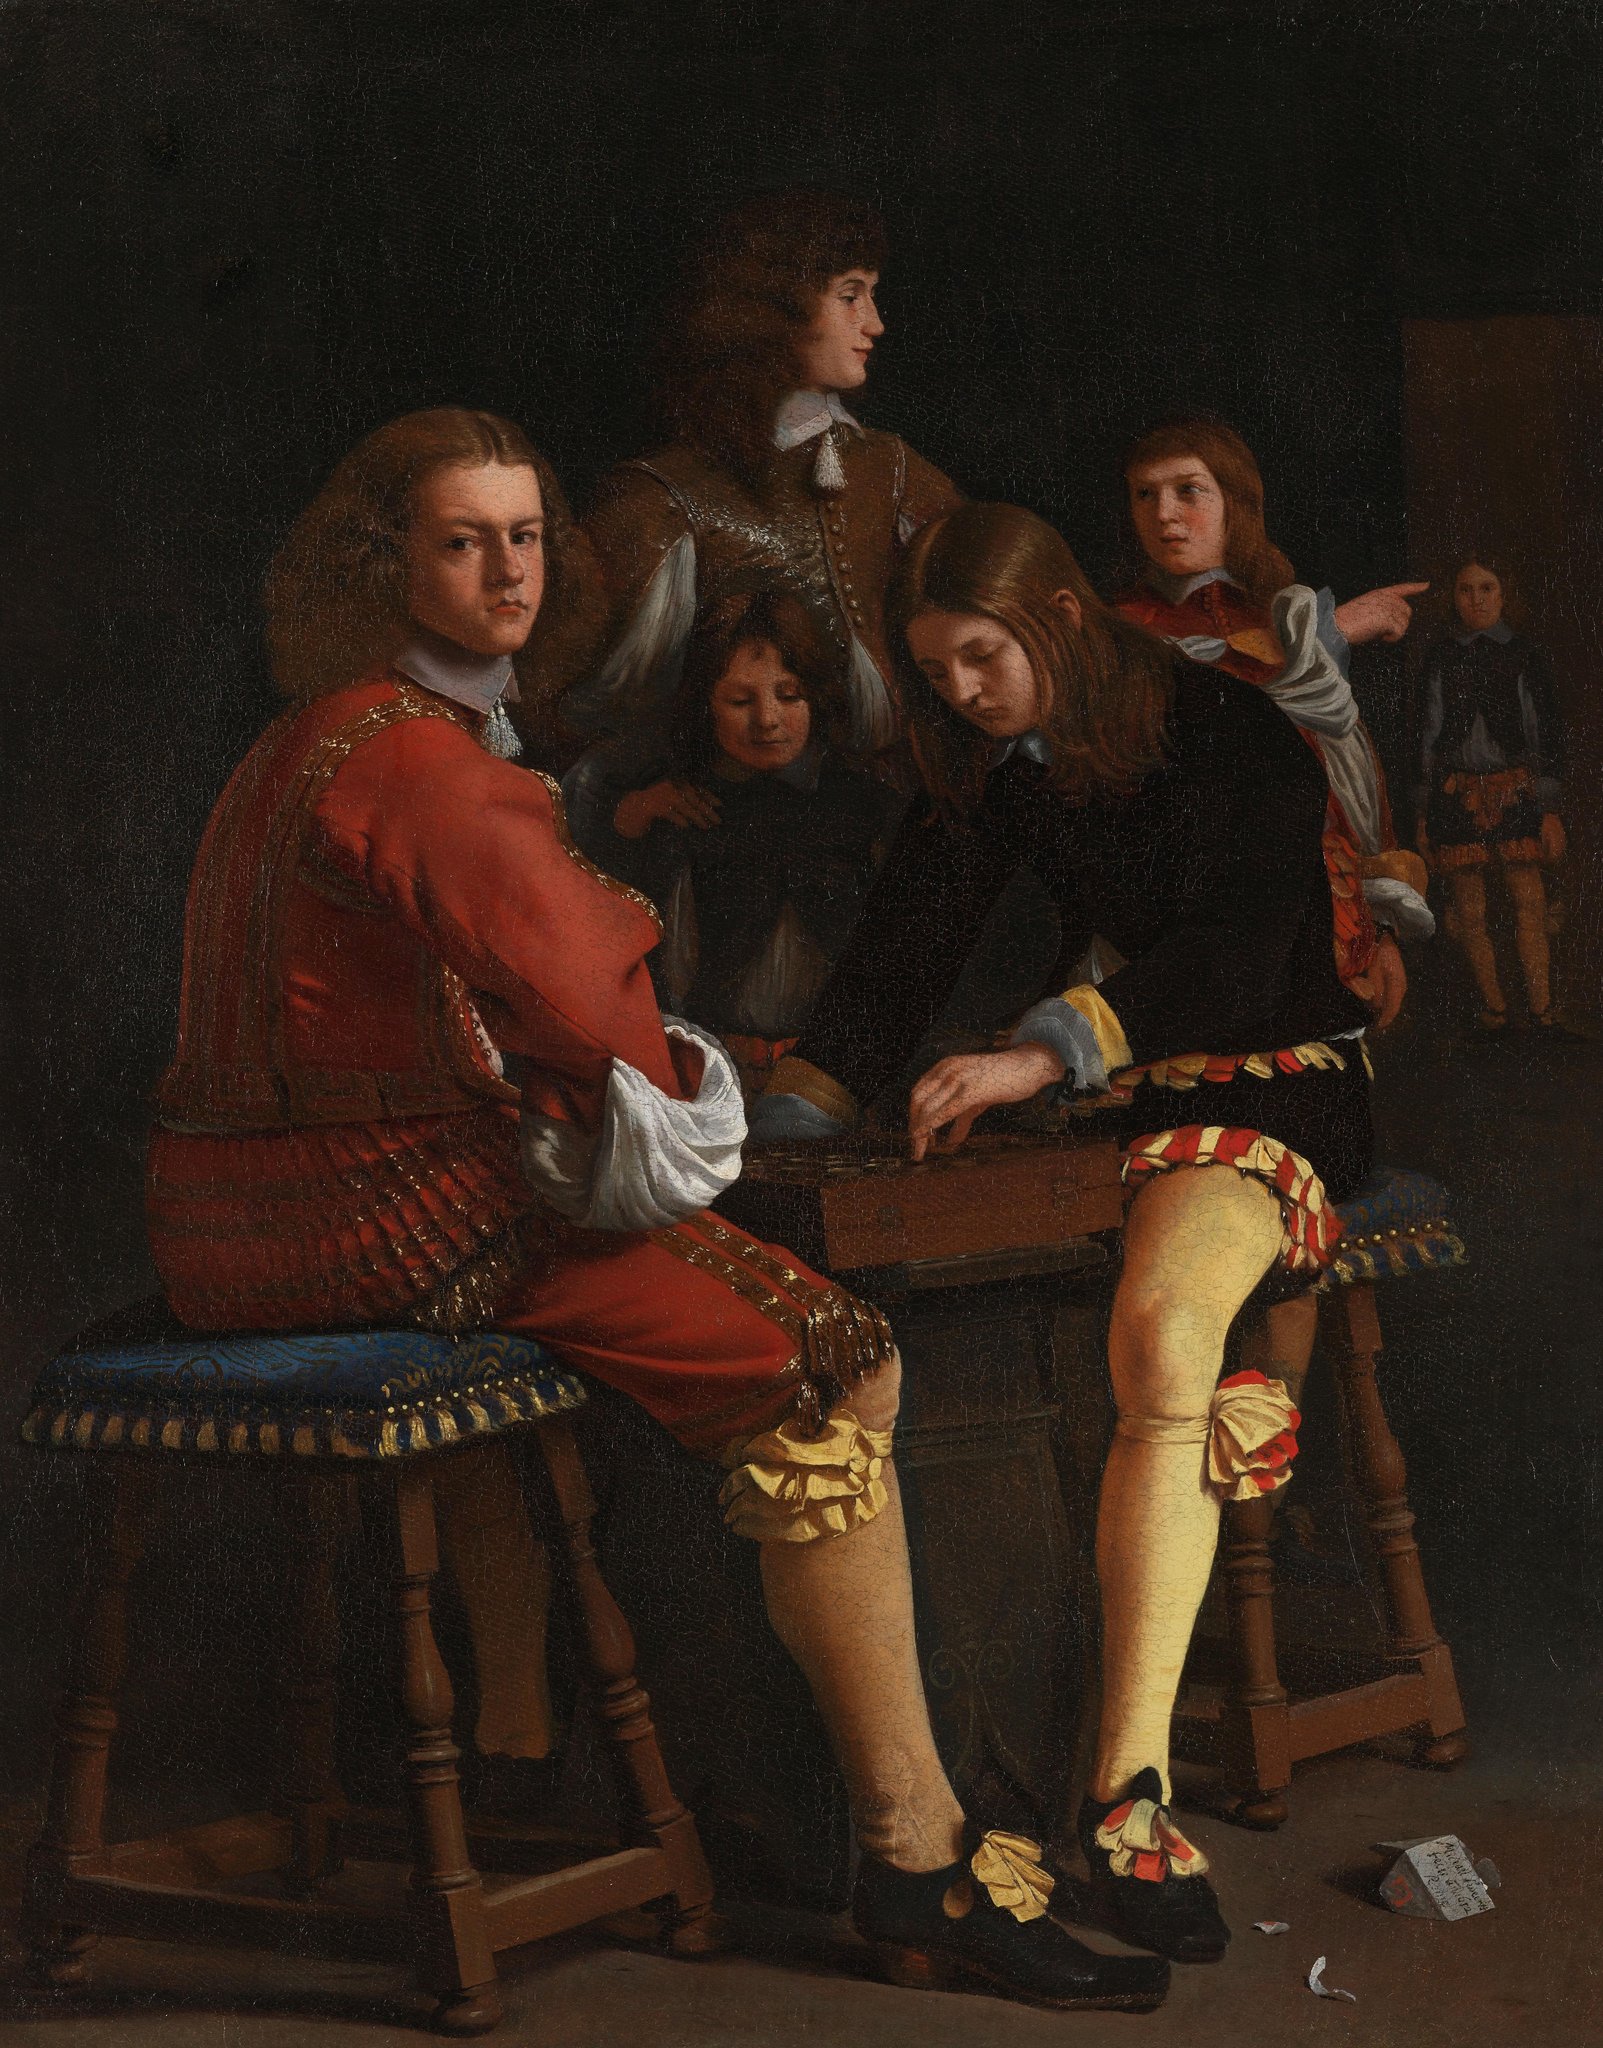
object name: painting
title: The Draughts Players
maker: michael sweerts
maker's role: painter, print maker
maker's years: 1618-1664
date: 1652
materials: canvas, oil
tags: draughts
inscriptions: signature and date: ‘Michael Sweerts fecit an. 1652 Roma’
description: De damspelers. Groep van vijf jongens, twee zijn gezeten op bankjes bezig met een spelletje dammen.